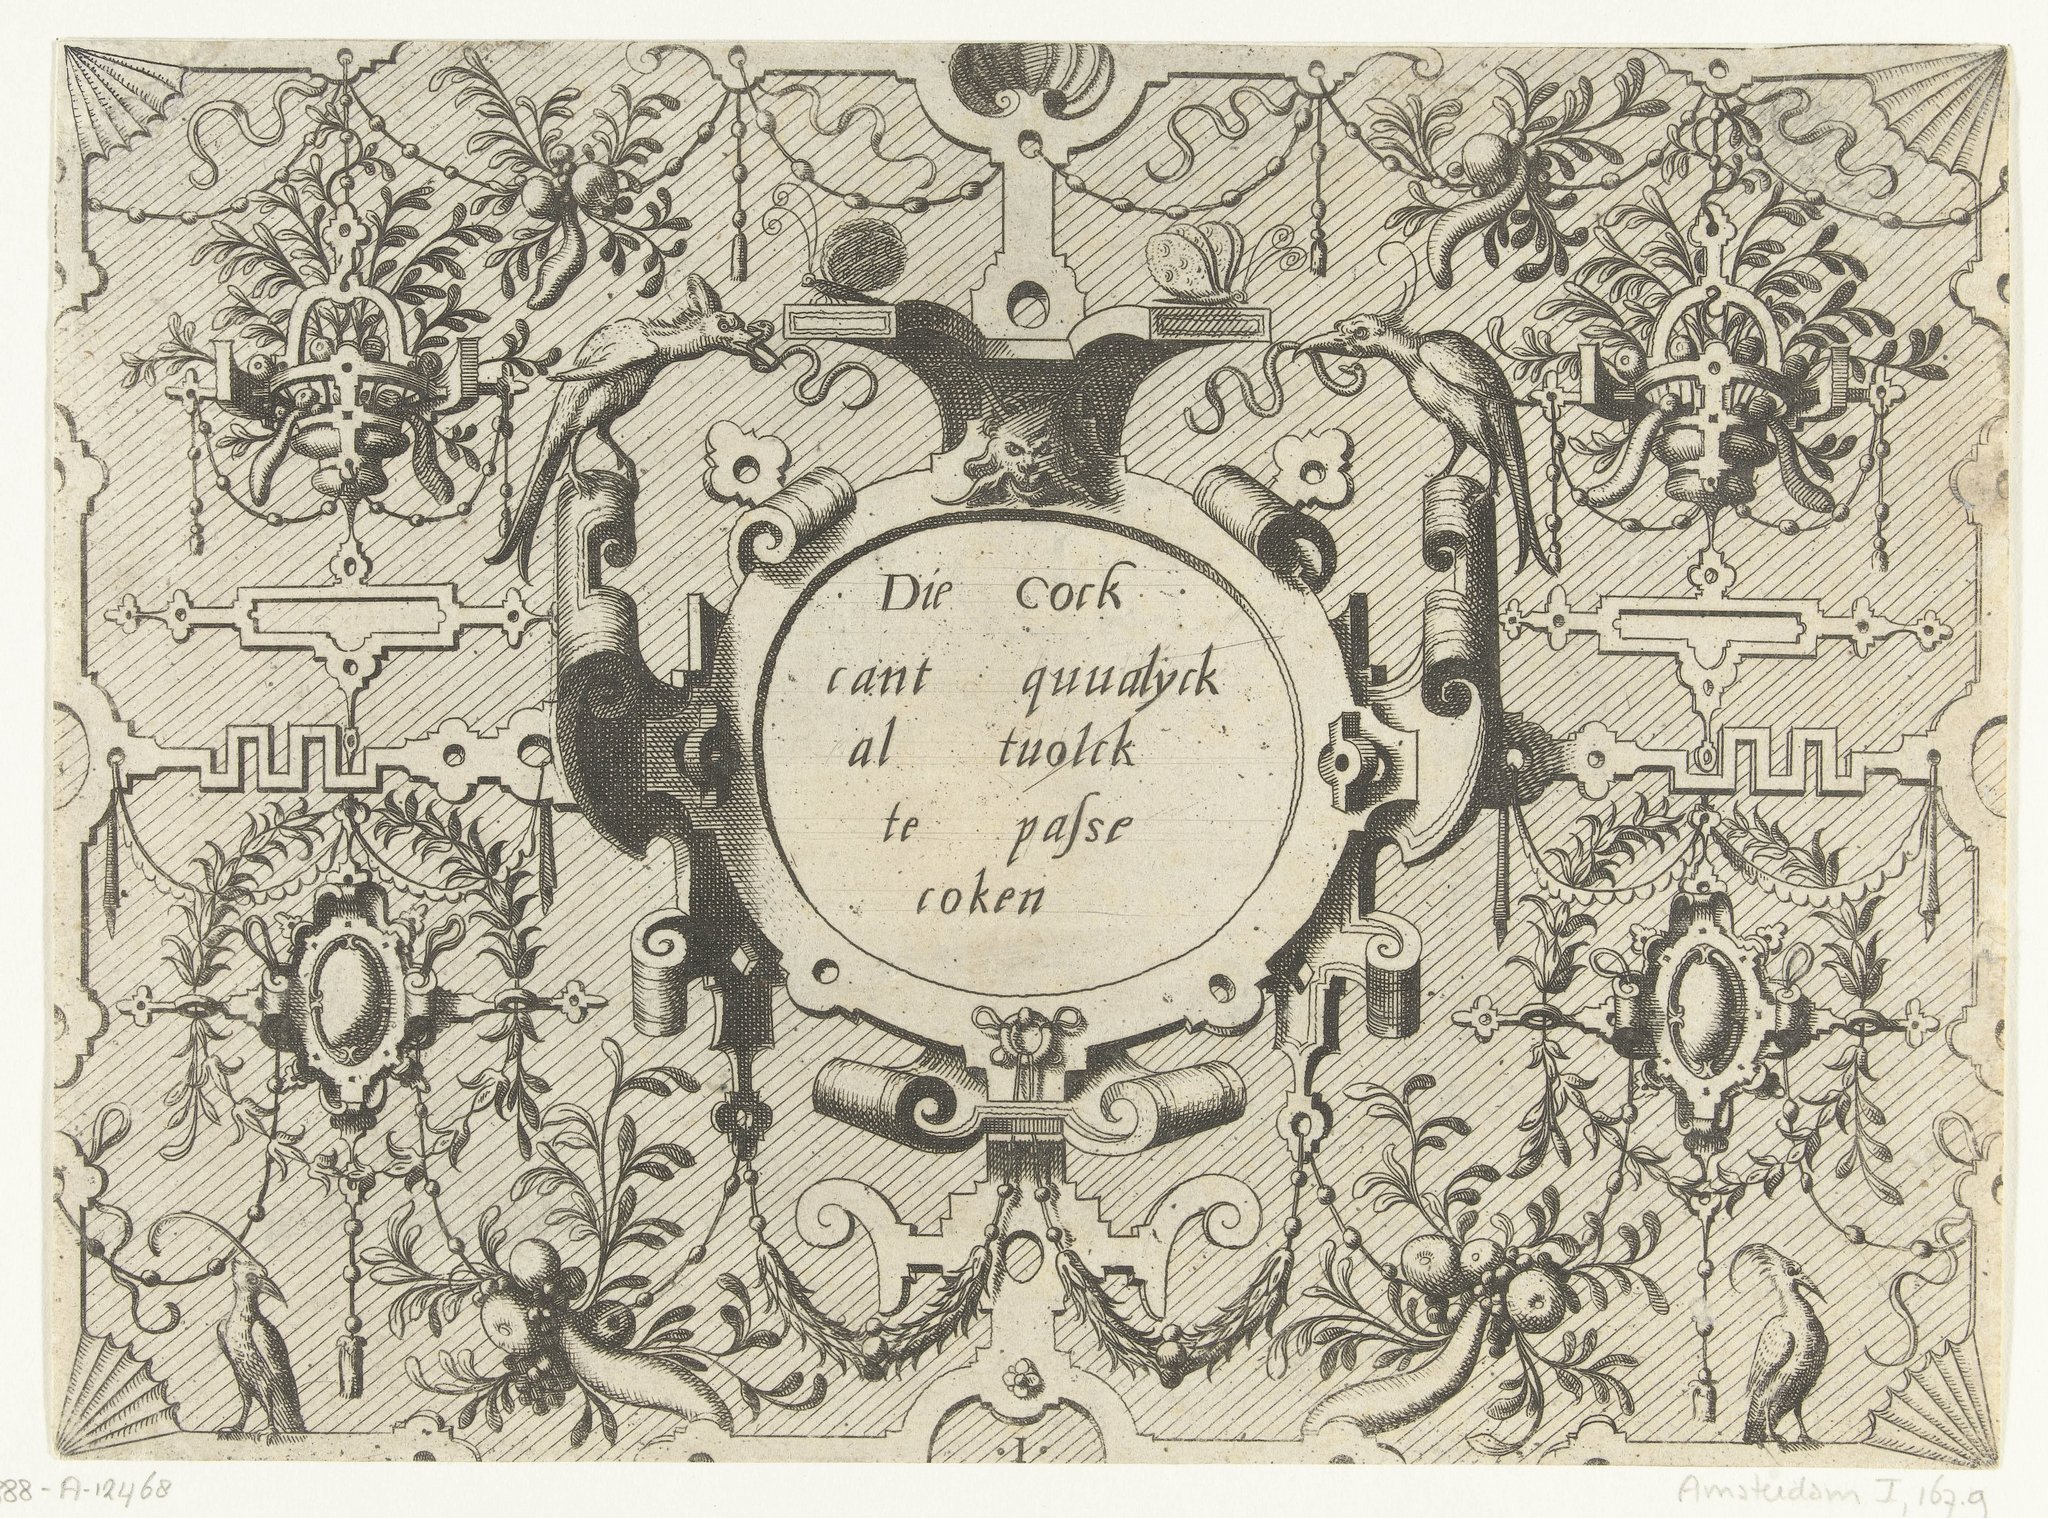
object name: ornament print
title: Cartouche omgeven door grotesken, links en rechts zit een vogel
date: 1555-1560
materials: paper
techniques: etching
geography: netherlands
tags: ornament ~ grotesque, cook, ornament ~ cartouche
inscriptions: inscription: ‘Die Cock/cant quualyck/al tuolck/te passe/coken’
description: Linksboven en rechtsboven zit een vogel met een aal in zijn snavel. Onderaan hangen guirlandes met vruchtentrossen. Blad I uit serie van 16 bladen, geletterd A-Q. Gearceerde of gestippelde achtergrond.